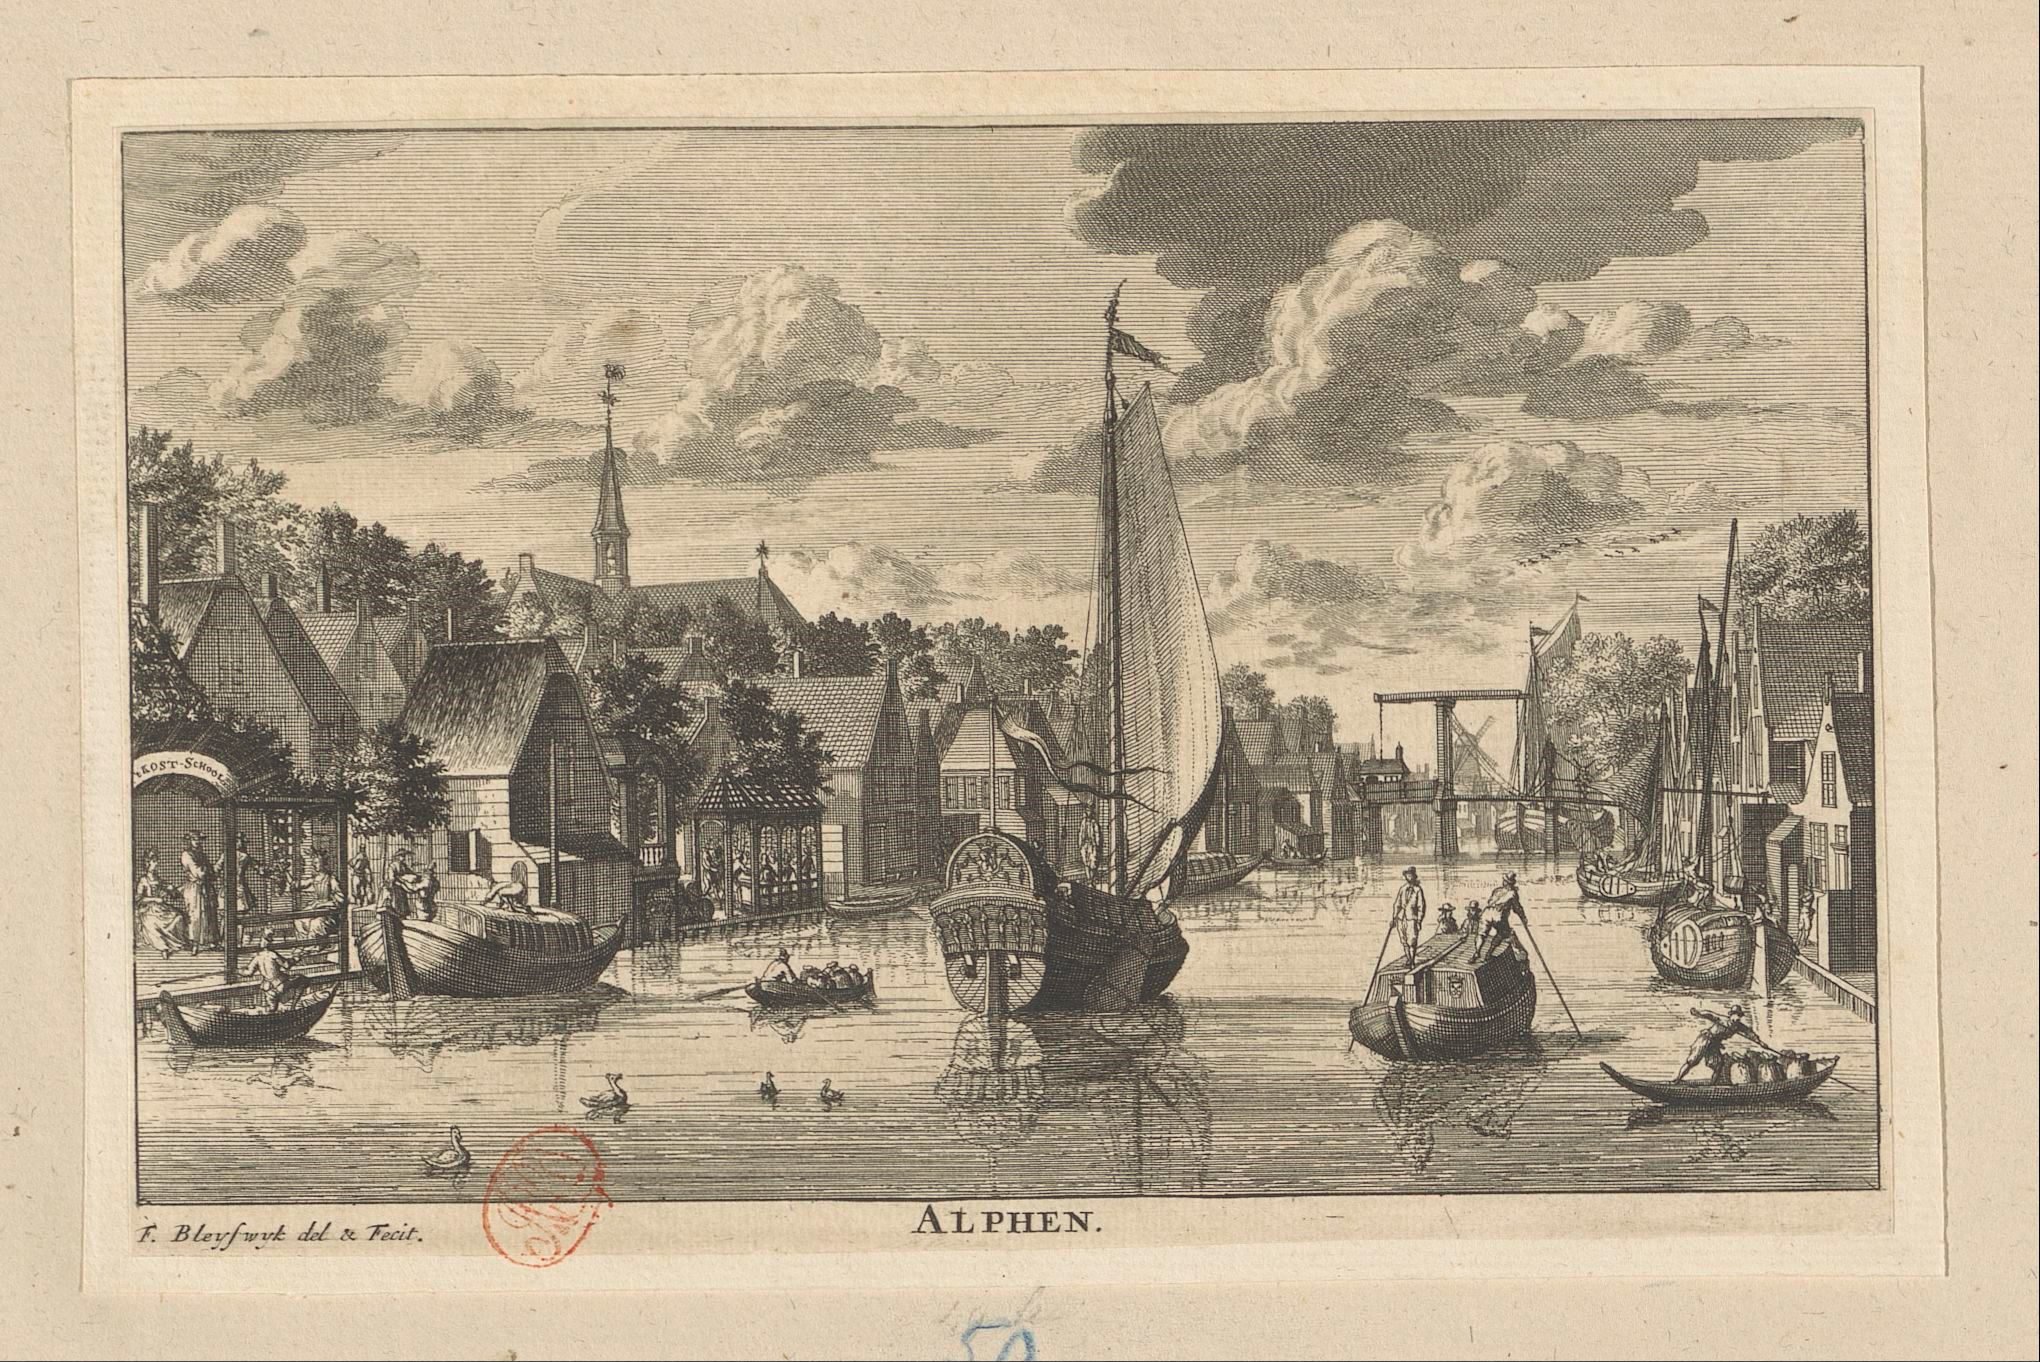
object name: print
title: Gezicht op Alphen aan den Rijn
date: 1714-1728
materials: paper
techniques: etching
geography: leiden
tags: prospect of village, silhouette of village, sailing-ship, sailing-boat, church (exterior), rowing-boat, canoe, etc.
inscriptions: collector's mark: Lugt 195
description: Prent ook gebruikt in: Plemper, Pieter. Beschryving van de heerlykheid en het dorp Alphen aan den Ryn. D'aaloude herkomst, bevolking (…) Met konst-printen geciert. 1e druk. Leiden: Hendrik van Damme, 1714. Of in: Plemper, Pieter. Oudheeden van de heerlykheid en het dorp Alphen aan den Ryn. D'aaloude herkomst, bevolking (…) Met konst-printen geciert. 2e druk. Leiden: Hendrik en Daniel van Damme, 1728.